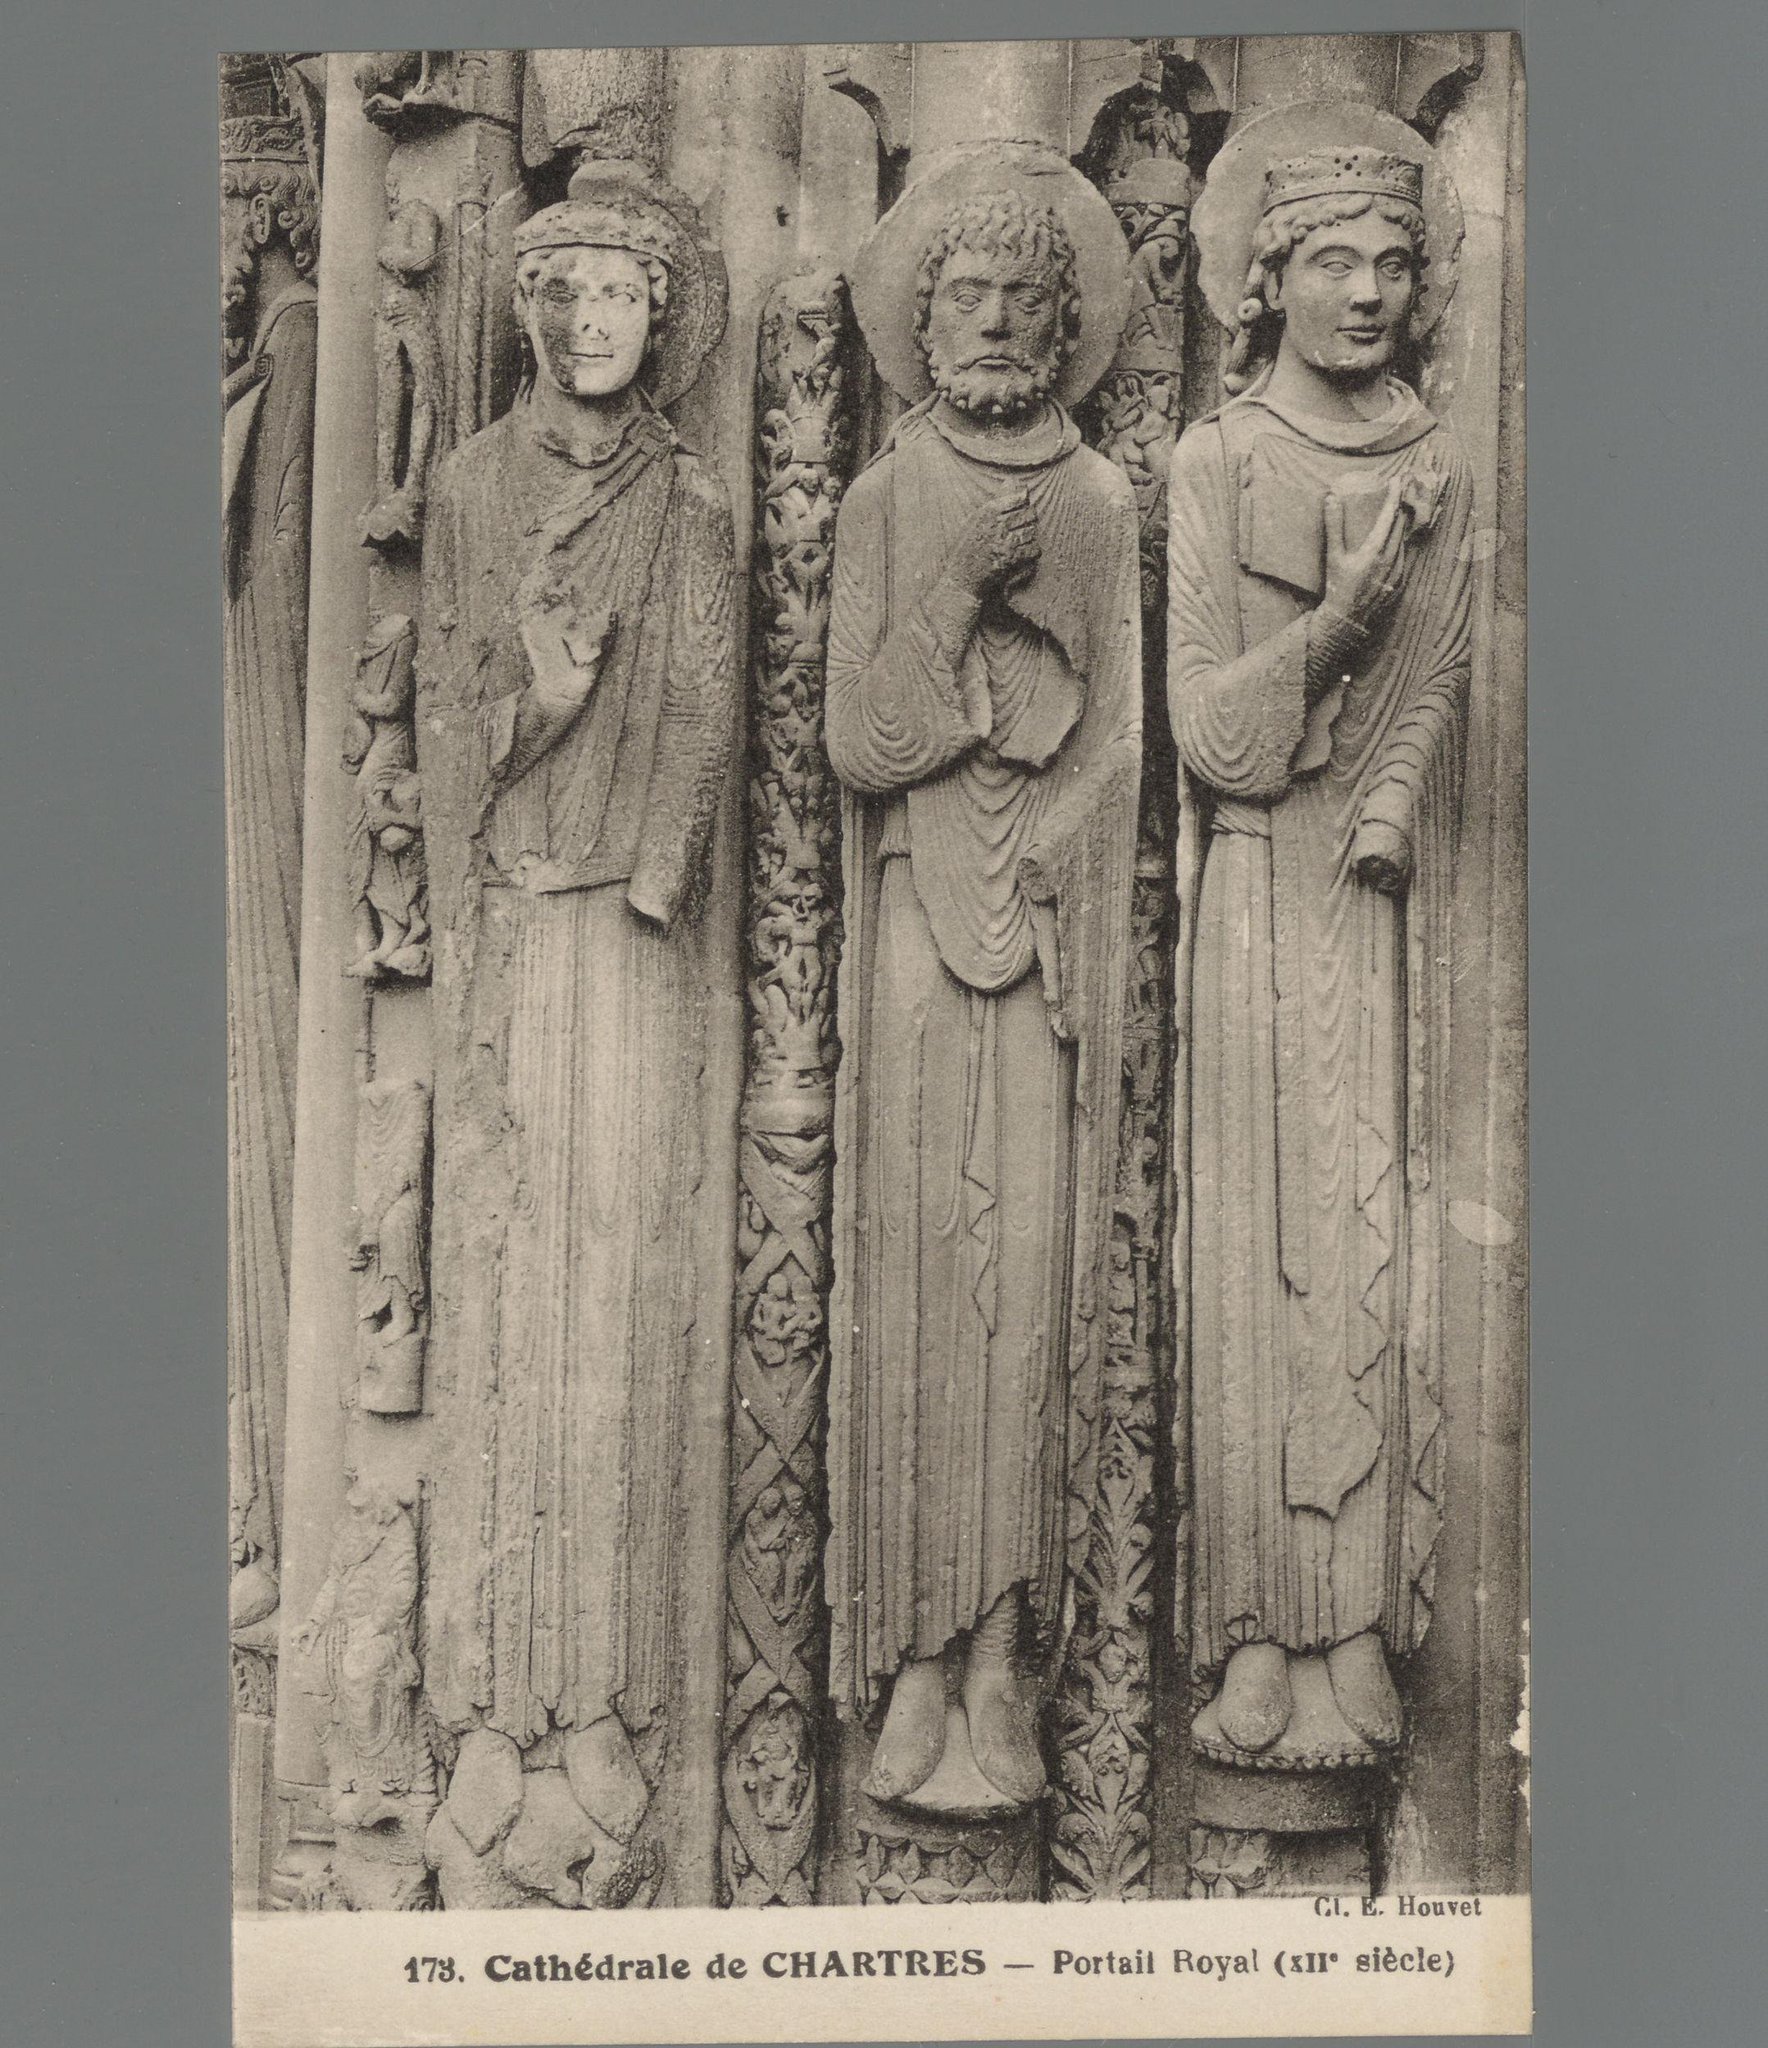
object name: photomechanical print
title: Cathédrale de Chartres - Portail Royal (XIIe siècle)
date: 1903-1930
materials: cardboard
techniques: photograph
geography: chartres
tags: church (exterior), statues, paintings, etc. ~ objects of worship in roman religion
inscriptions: collector's mark: ‘AFE v S’